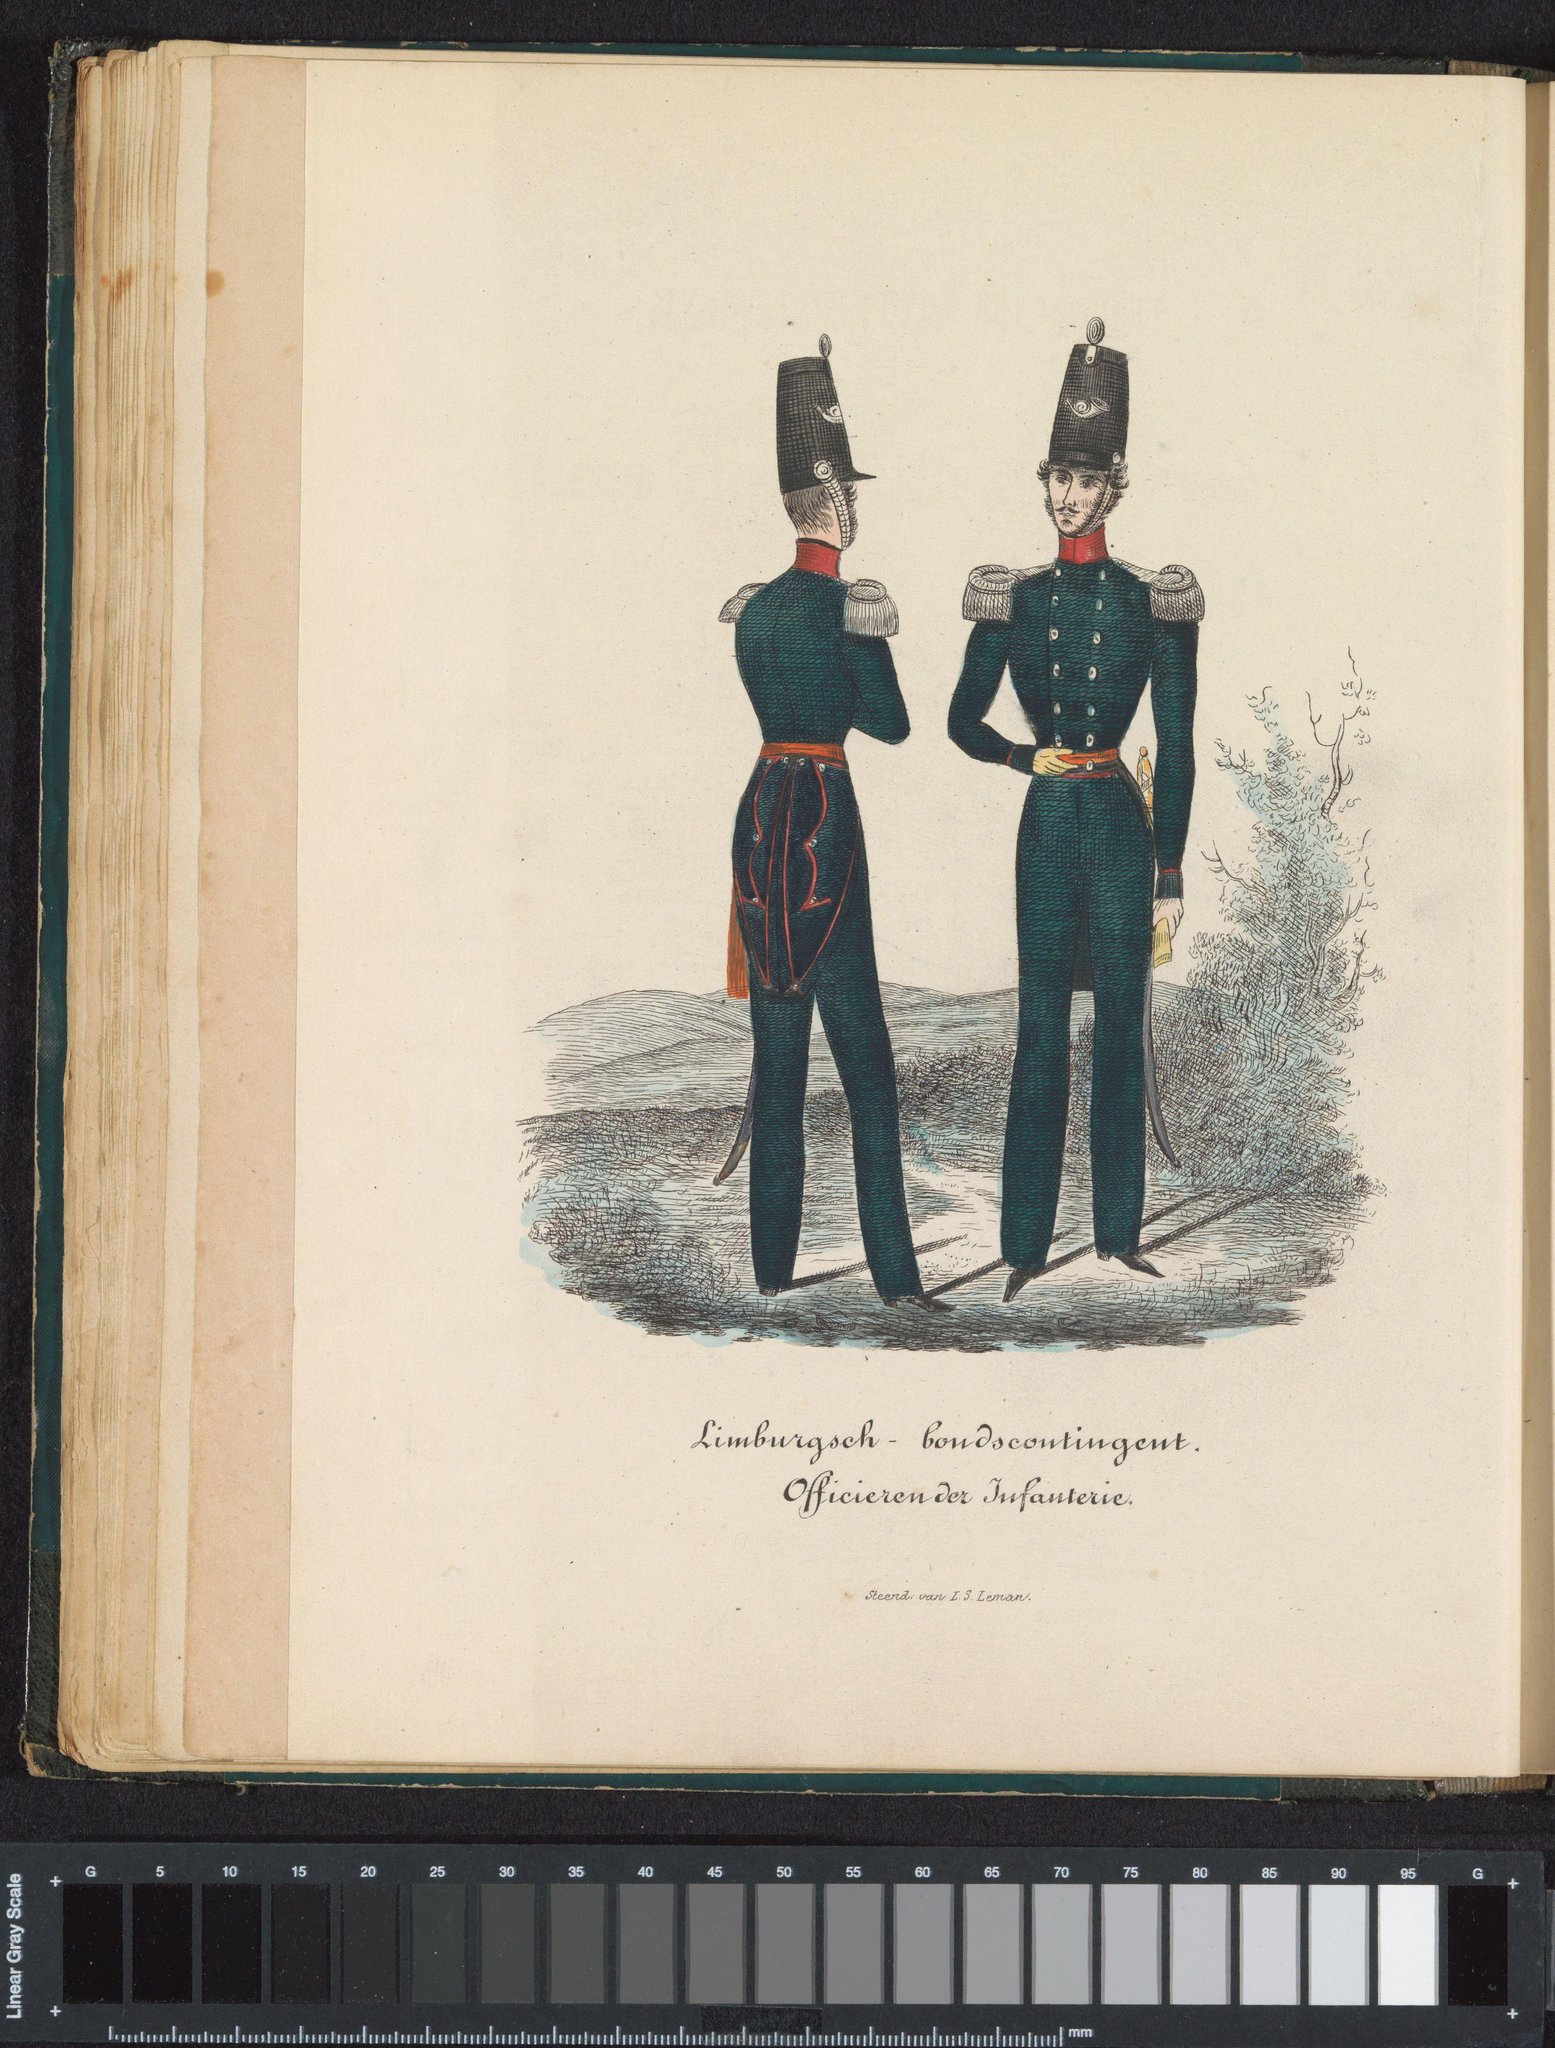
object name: costume print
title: Limburgsch bonds-Contingent. Officieren der Infanterie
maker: louis salomon leman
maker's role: steendrukker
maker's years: 1818-1889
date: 1845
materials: paper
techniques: hand coloring, lithograph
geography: netherlands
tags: (military) uniforms, netherlands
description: Uniform van de officieren van de infanterie van het Limburgs Bondscontingent. Illustratie in een boek uit 1845 over de uniformen en kledingstukken van de Nederlandse land-, zeemacht en schutterijen in Nederland en in de overzeese gebiedsdelen.